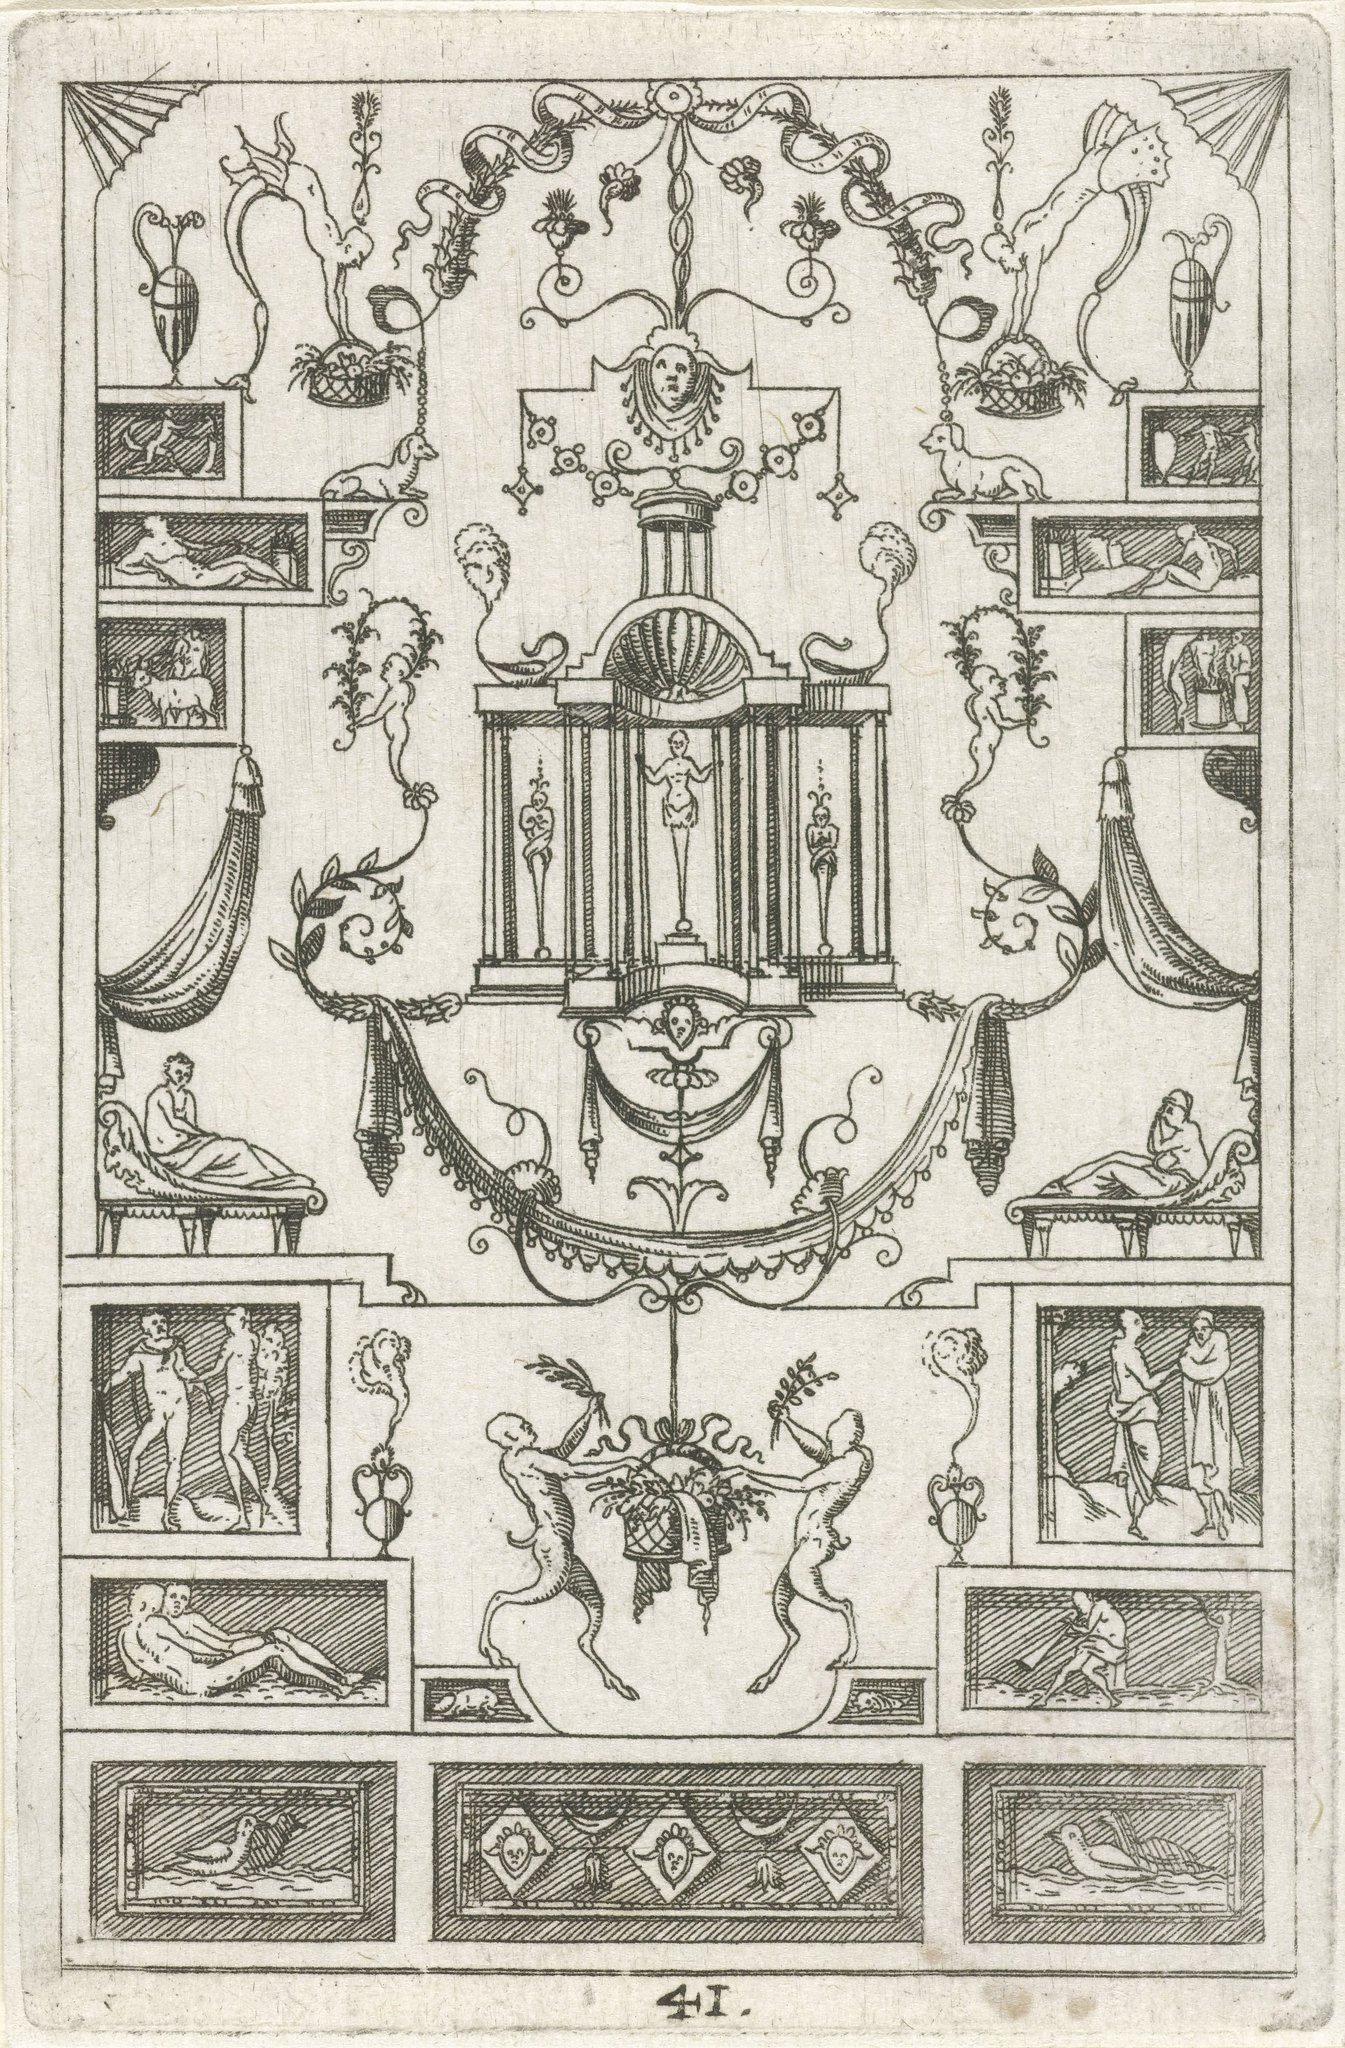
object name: ornament print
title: Vlakdecoratie met in het midden twee saters ter weerszijden van een mand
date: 1525-1594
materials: paper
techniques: etching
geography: germany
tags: container made of plant material other than wood: basket, satyr(s) (in general)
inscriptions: collector's mark: Lugt 240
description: Gelijkzijdige kopie naar prent van Jacques Androuet Ducerceau, ontleend aan een vlakdecoratie van Enea Vico. Blad uit serie met architectuurfantasieën en grotesken met fabelwezens, guirlandes, kandelabers en mascarons.